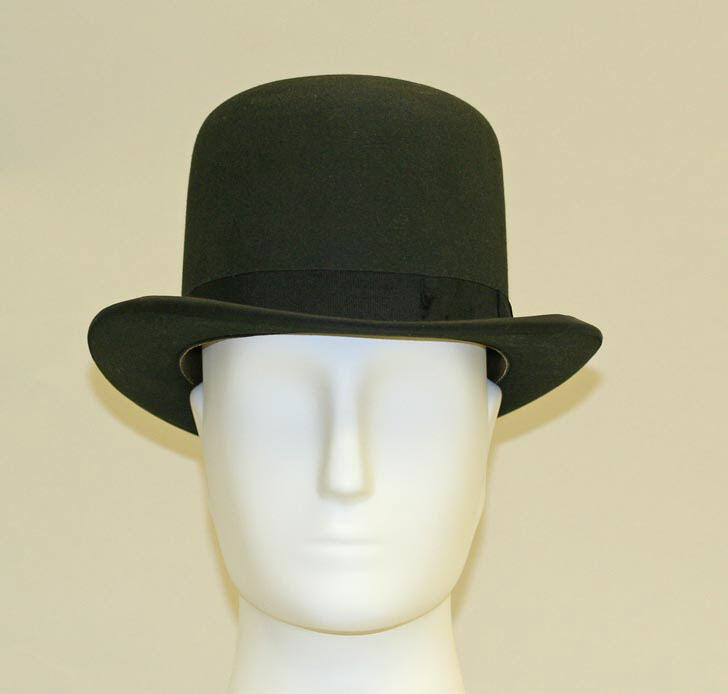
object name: derby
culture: american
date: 1880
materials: wool